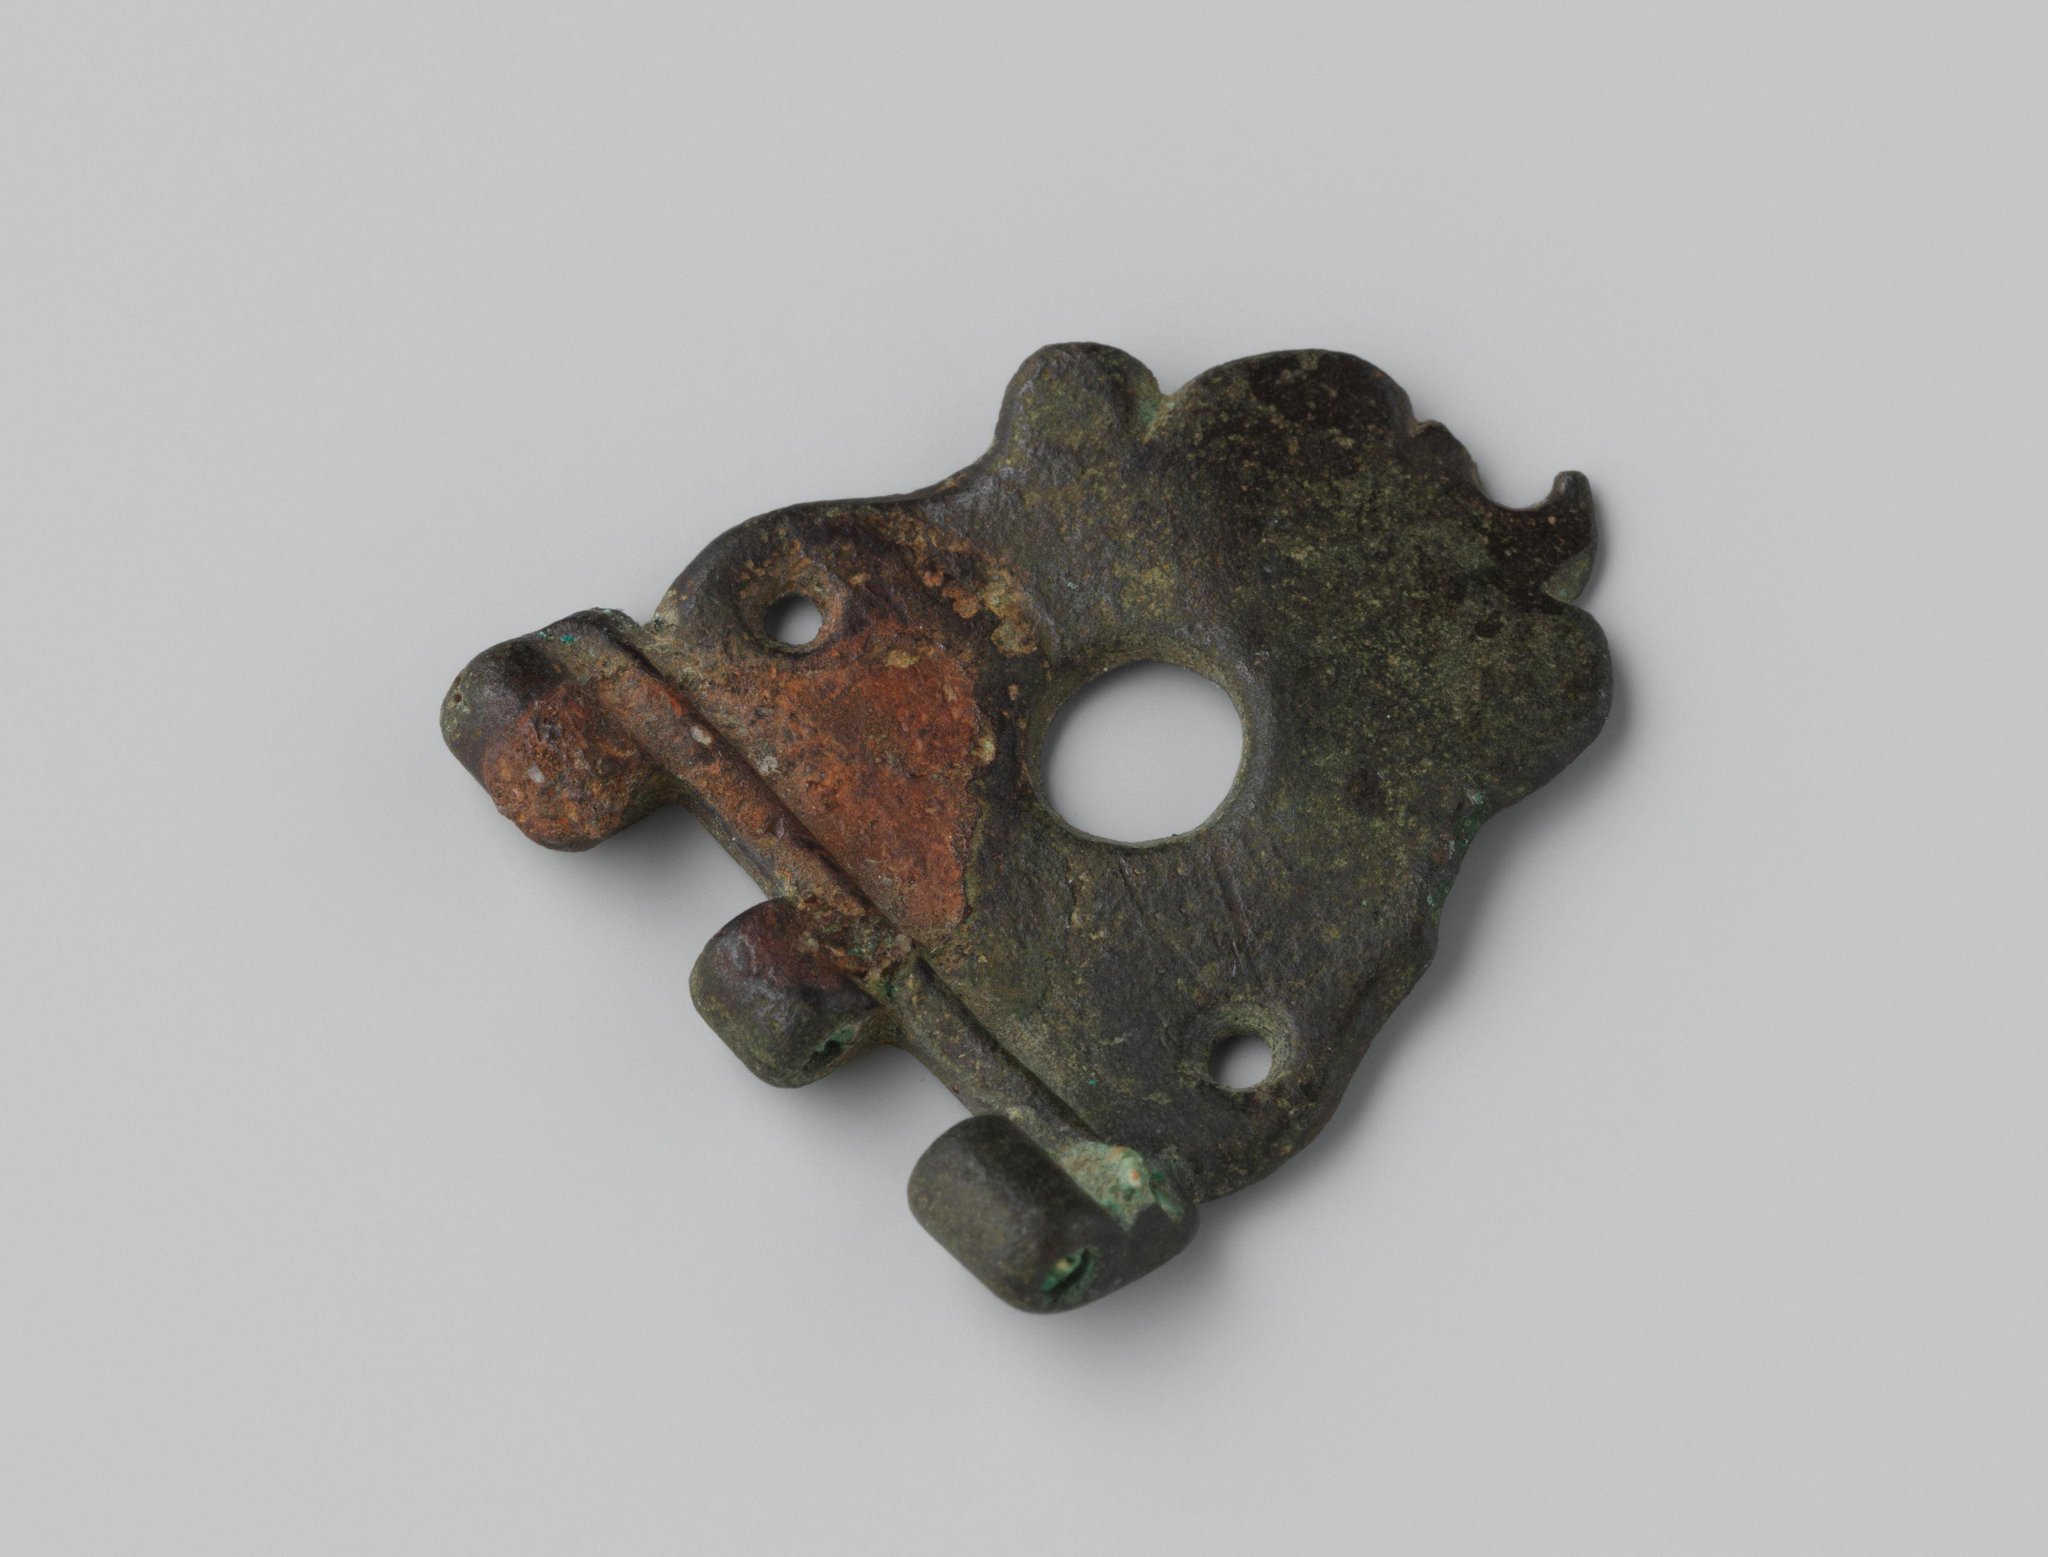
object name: scharnier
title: Scharnier uit het wrak van de Oost-Indiëvaarder Hollandia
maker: Anonymous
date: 1700-1743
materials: copper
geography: netherlands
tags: verenigde oostindische compagnie, hollandia (schip), annet